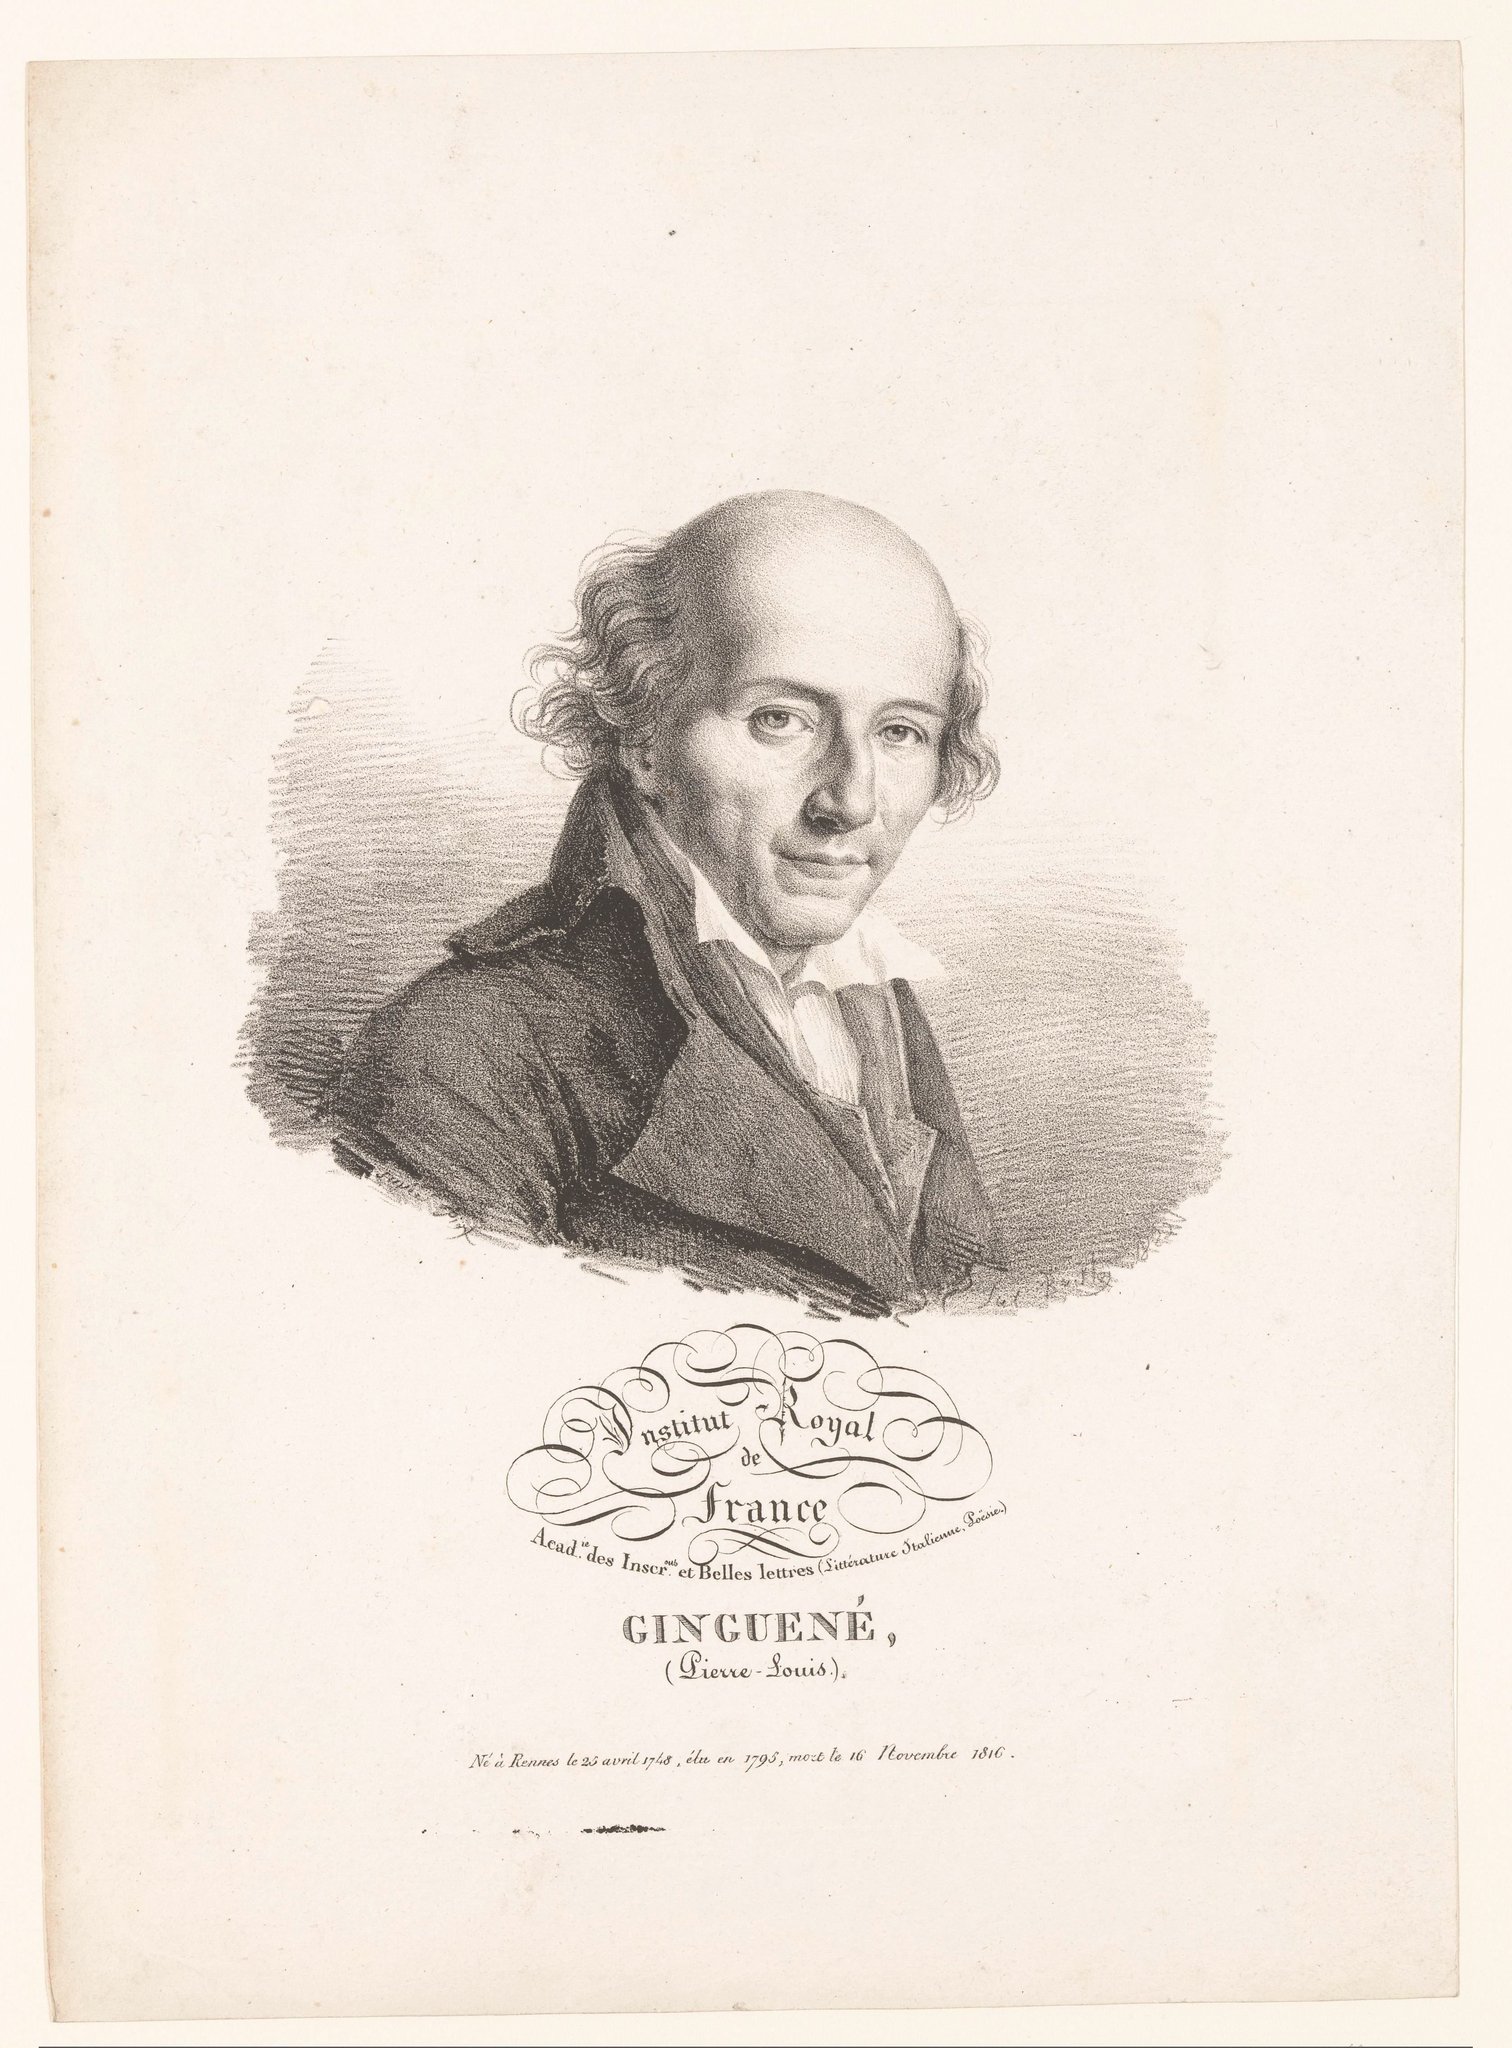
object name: print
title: Ginguené, Pierre-Louis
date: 1822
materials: paper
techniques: lithograph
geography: paris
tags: paris, pierre-louis ginguené, historical persons, portrait of a writer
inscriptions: collector's mark: Lugt 2228a